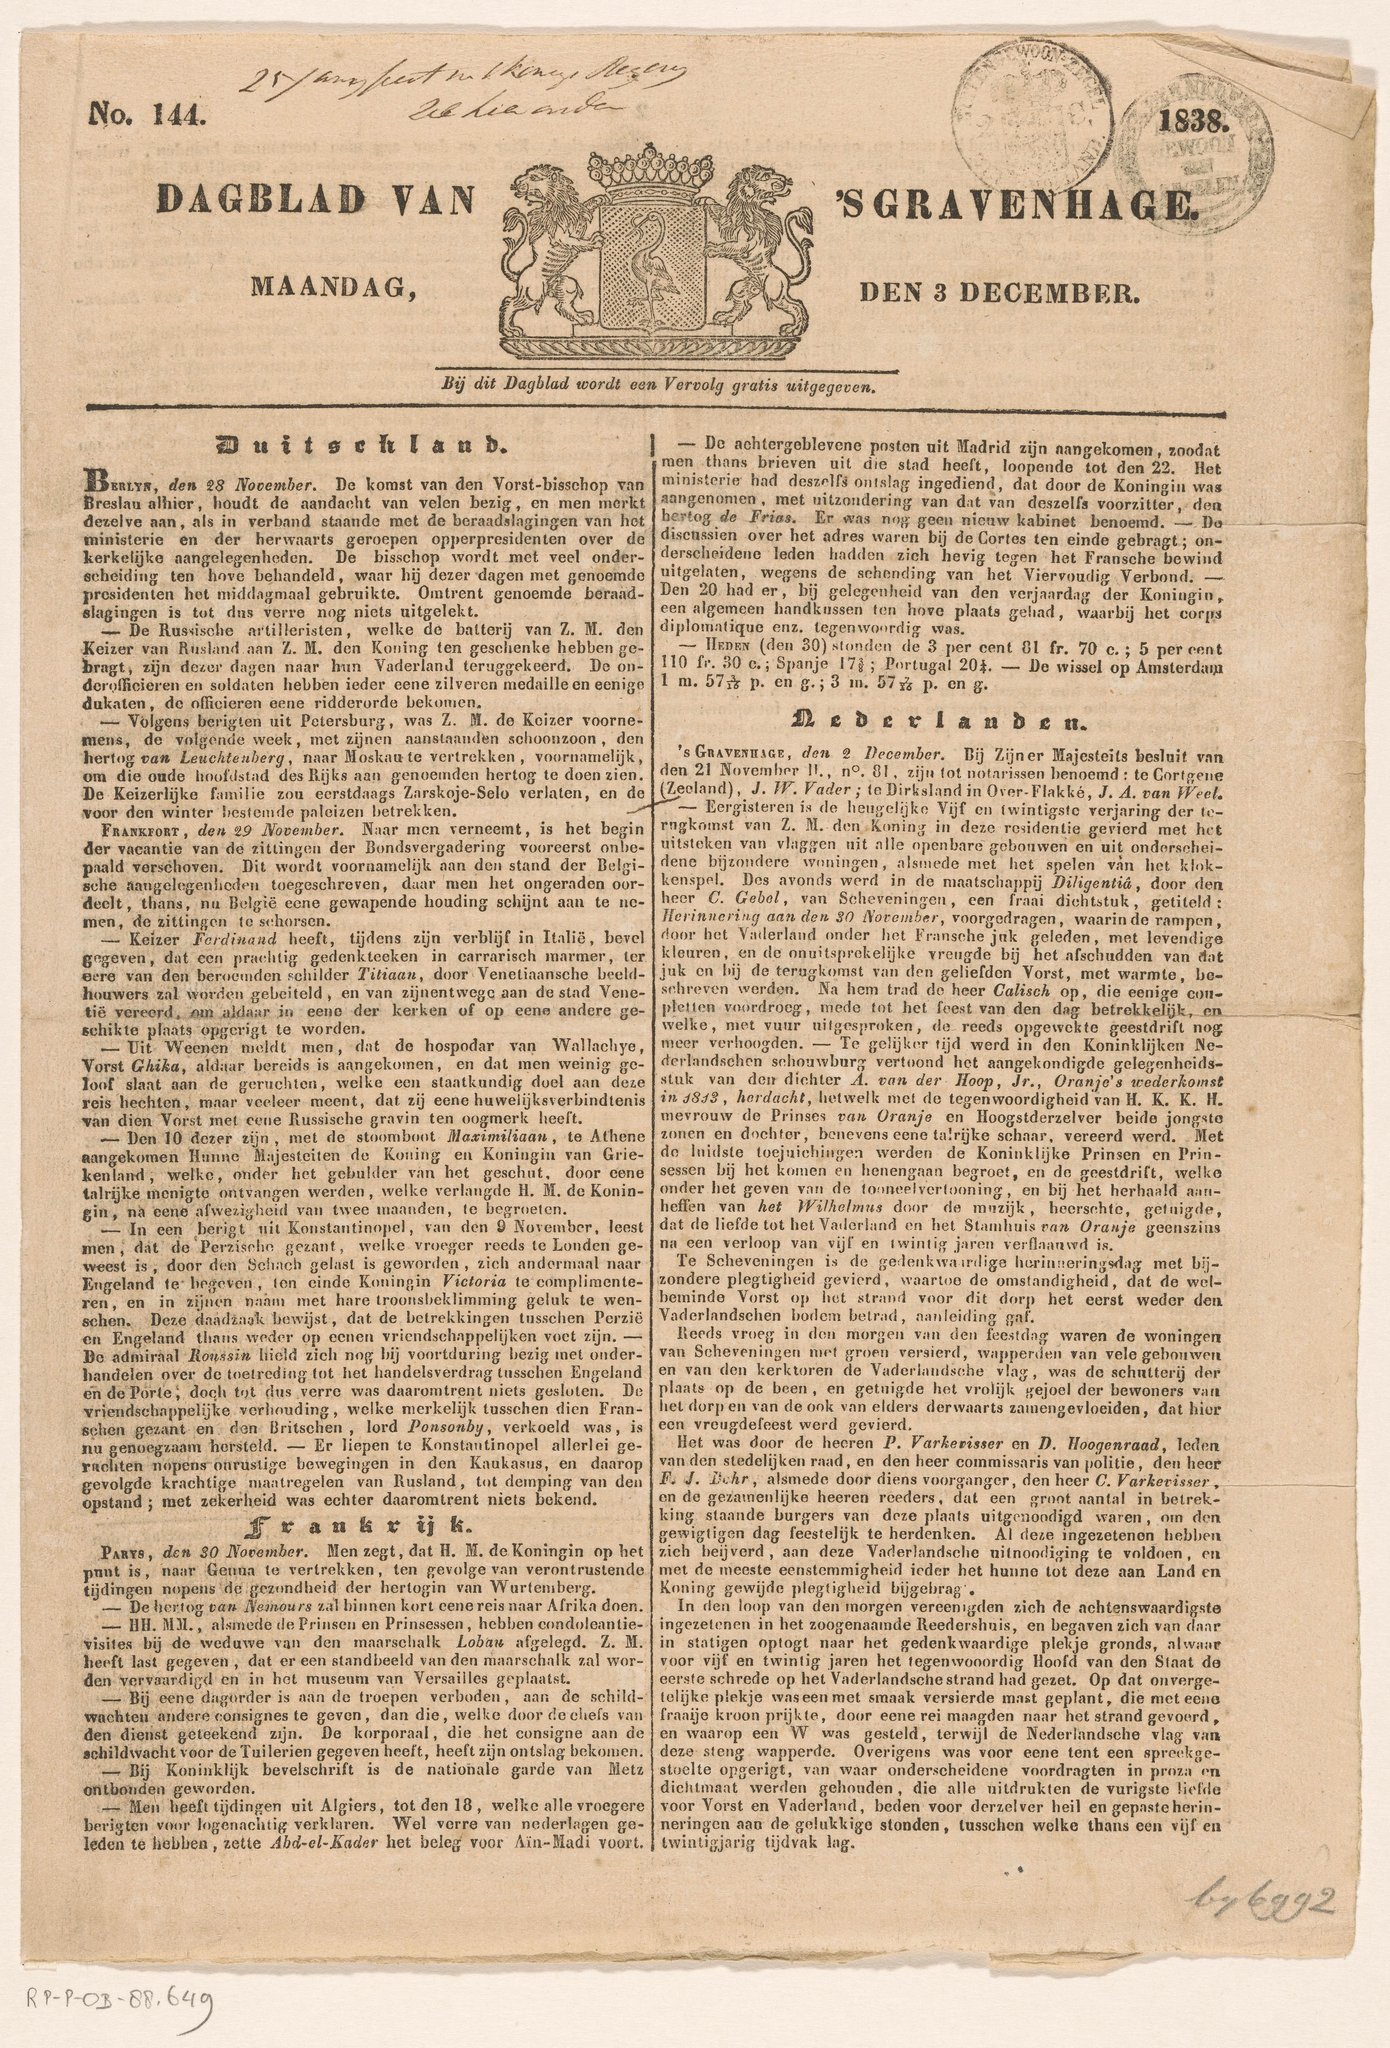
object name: newspaper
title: Dagblad van 's Gravenhage. Maandag, den 3 December. No. 144. 1838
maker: p.e. van staden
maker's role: printer, publisher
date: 1838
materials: paper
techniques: letterpress printing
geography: the hague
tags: the hague, william i of the netherlands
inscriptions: collector's mark: Lugt 2228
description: Exemplaar het 'Dagblad van 's Gravenhage' van 3 december 1838, met berichten over de viering van het vijfentwintigjarige regeringsjubileum van koning Willem I in november 1838. Dubbelgevouwen blad bedrukt op alle zijden.